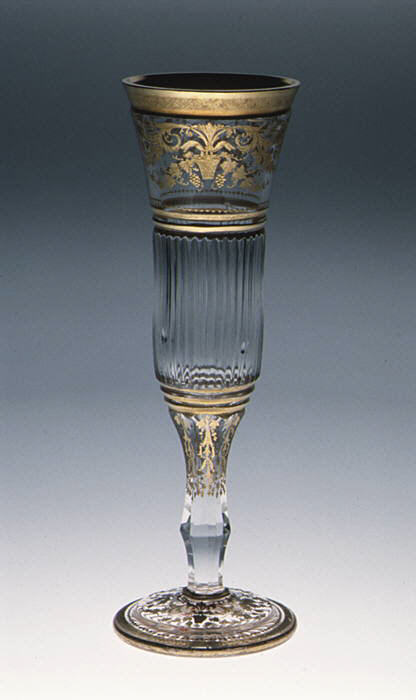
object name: champagne glass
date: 1830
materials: glass